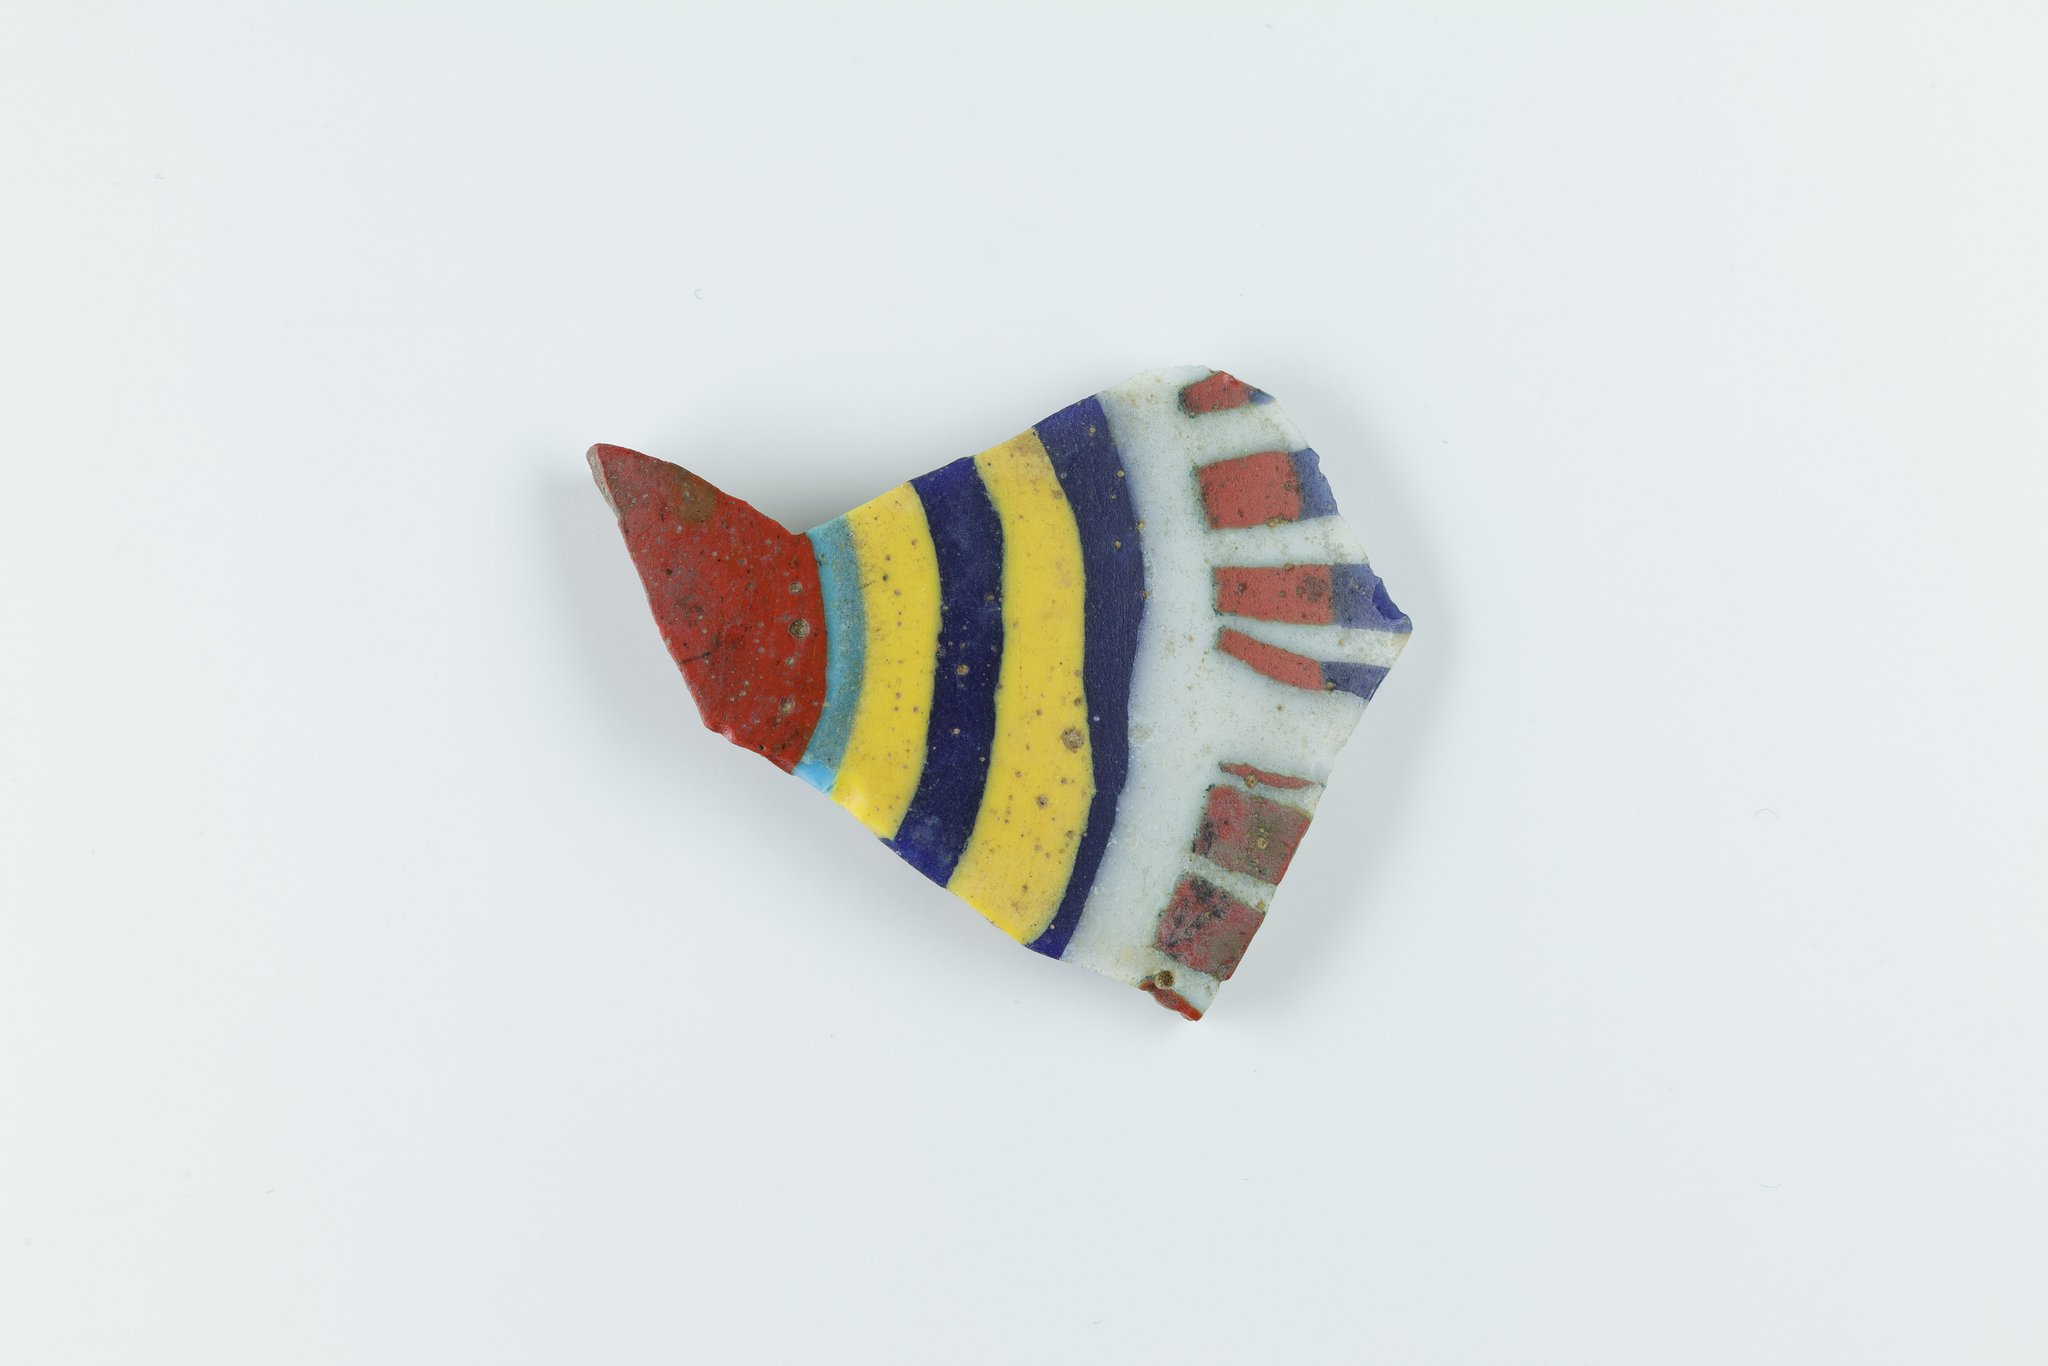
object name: fragment, mosaic bowl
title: Fragment of a Bowl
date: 1427-1400 BCE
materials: glass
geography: upper egypt, thebes